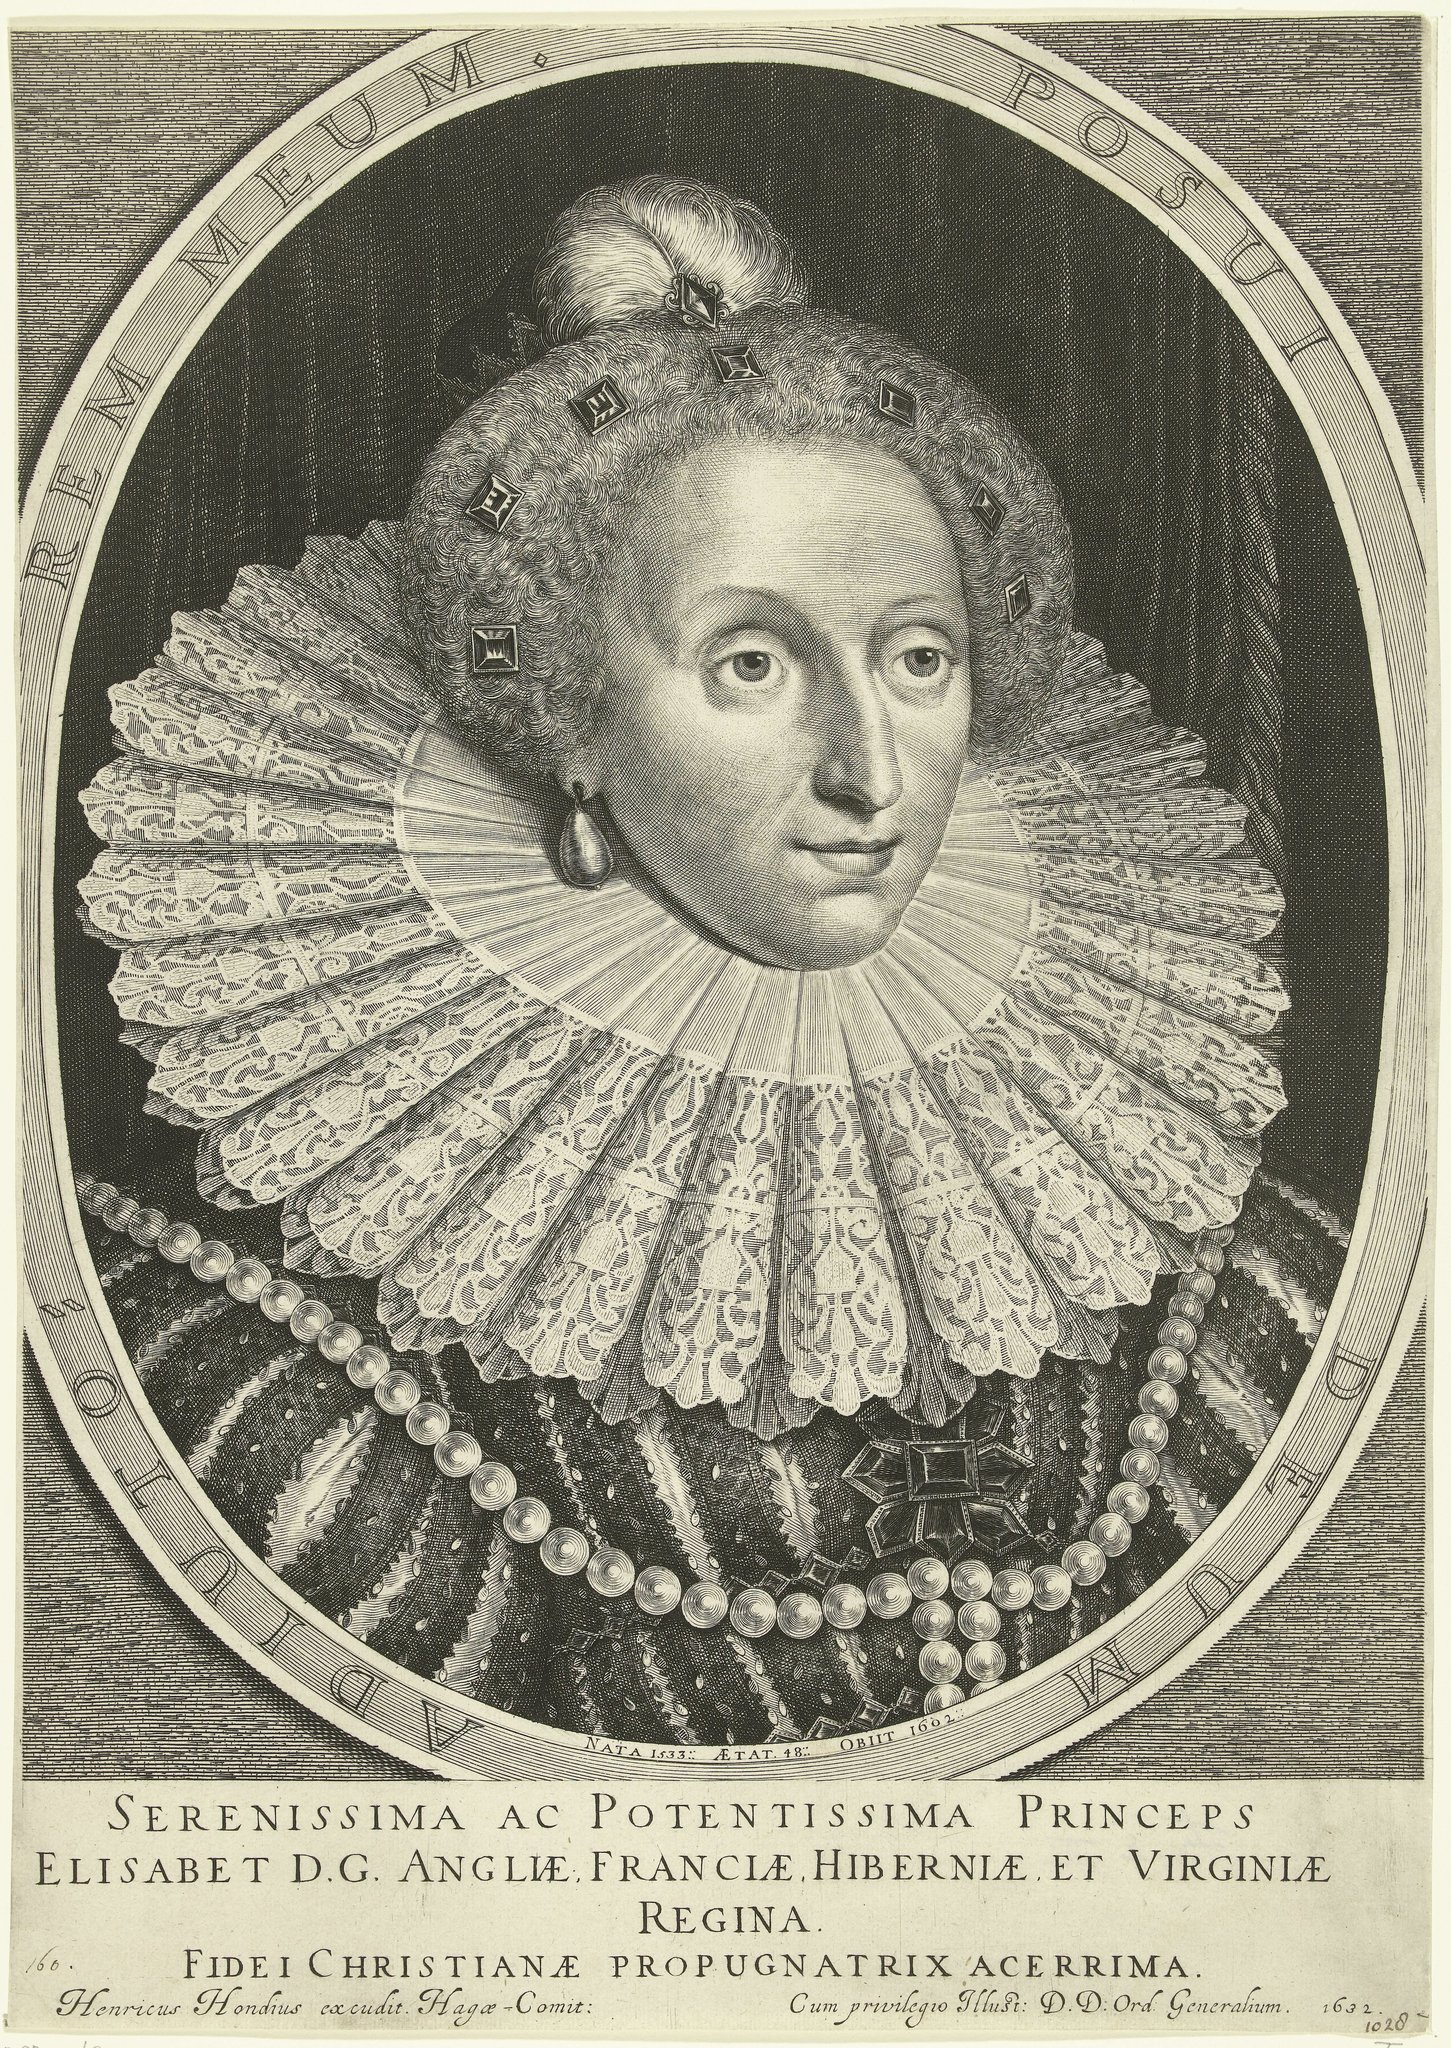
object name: print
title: Portret van Elizabeth I Tudor, koningin van Engeland op 48-jarige leeftijd in ovaal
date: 1632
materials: paper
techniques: engraving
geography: the hague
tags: ruler, sovereign - bb - female ruler, neck-gear: collar (+ women's clothes)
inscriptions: collector's mark: Lugt 2228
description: Portret van Elizabeth I Tudor, koningin van Engeland, op 48-jarige leeftijd, borststuk in ovaal met plooikraag en sieraden. Motto op ovale omlijsting, Latijns opschrift in ondermarge.